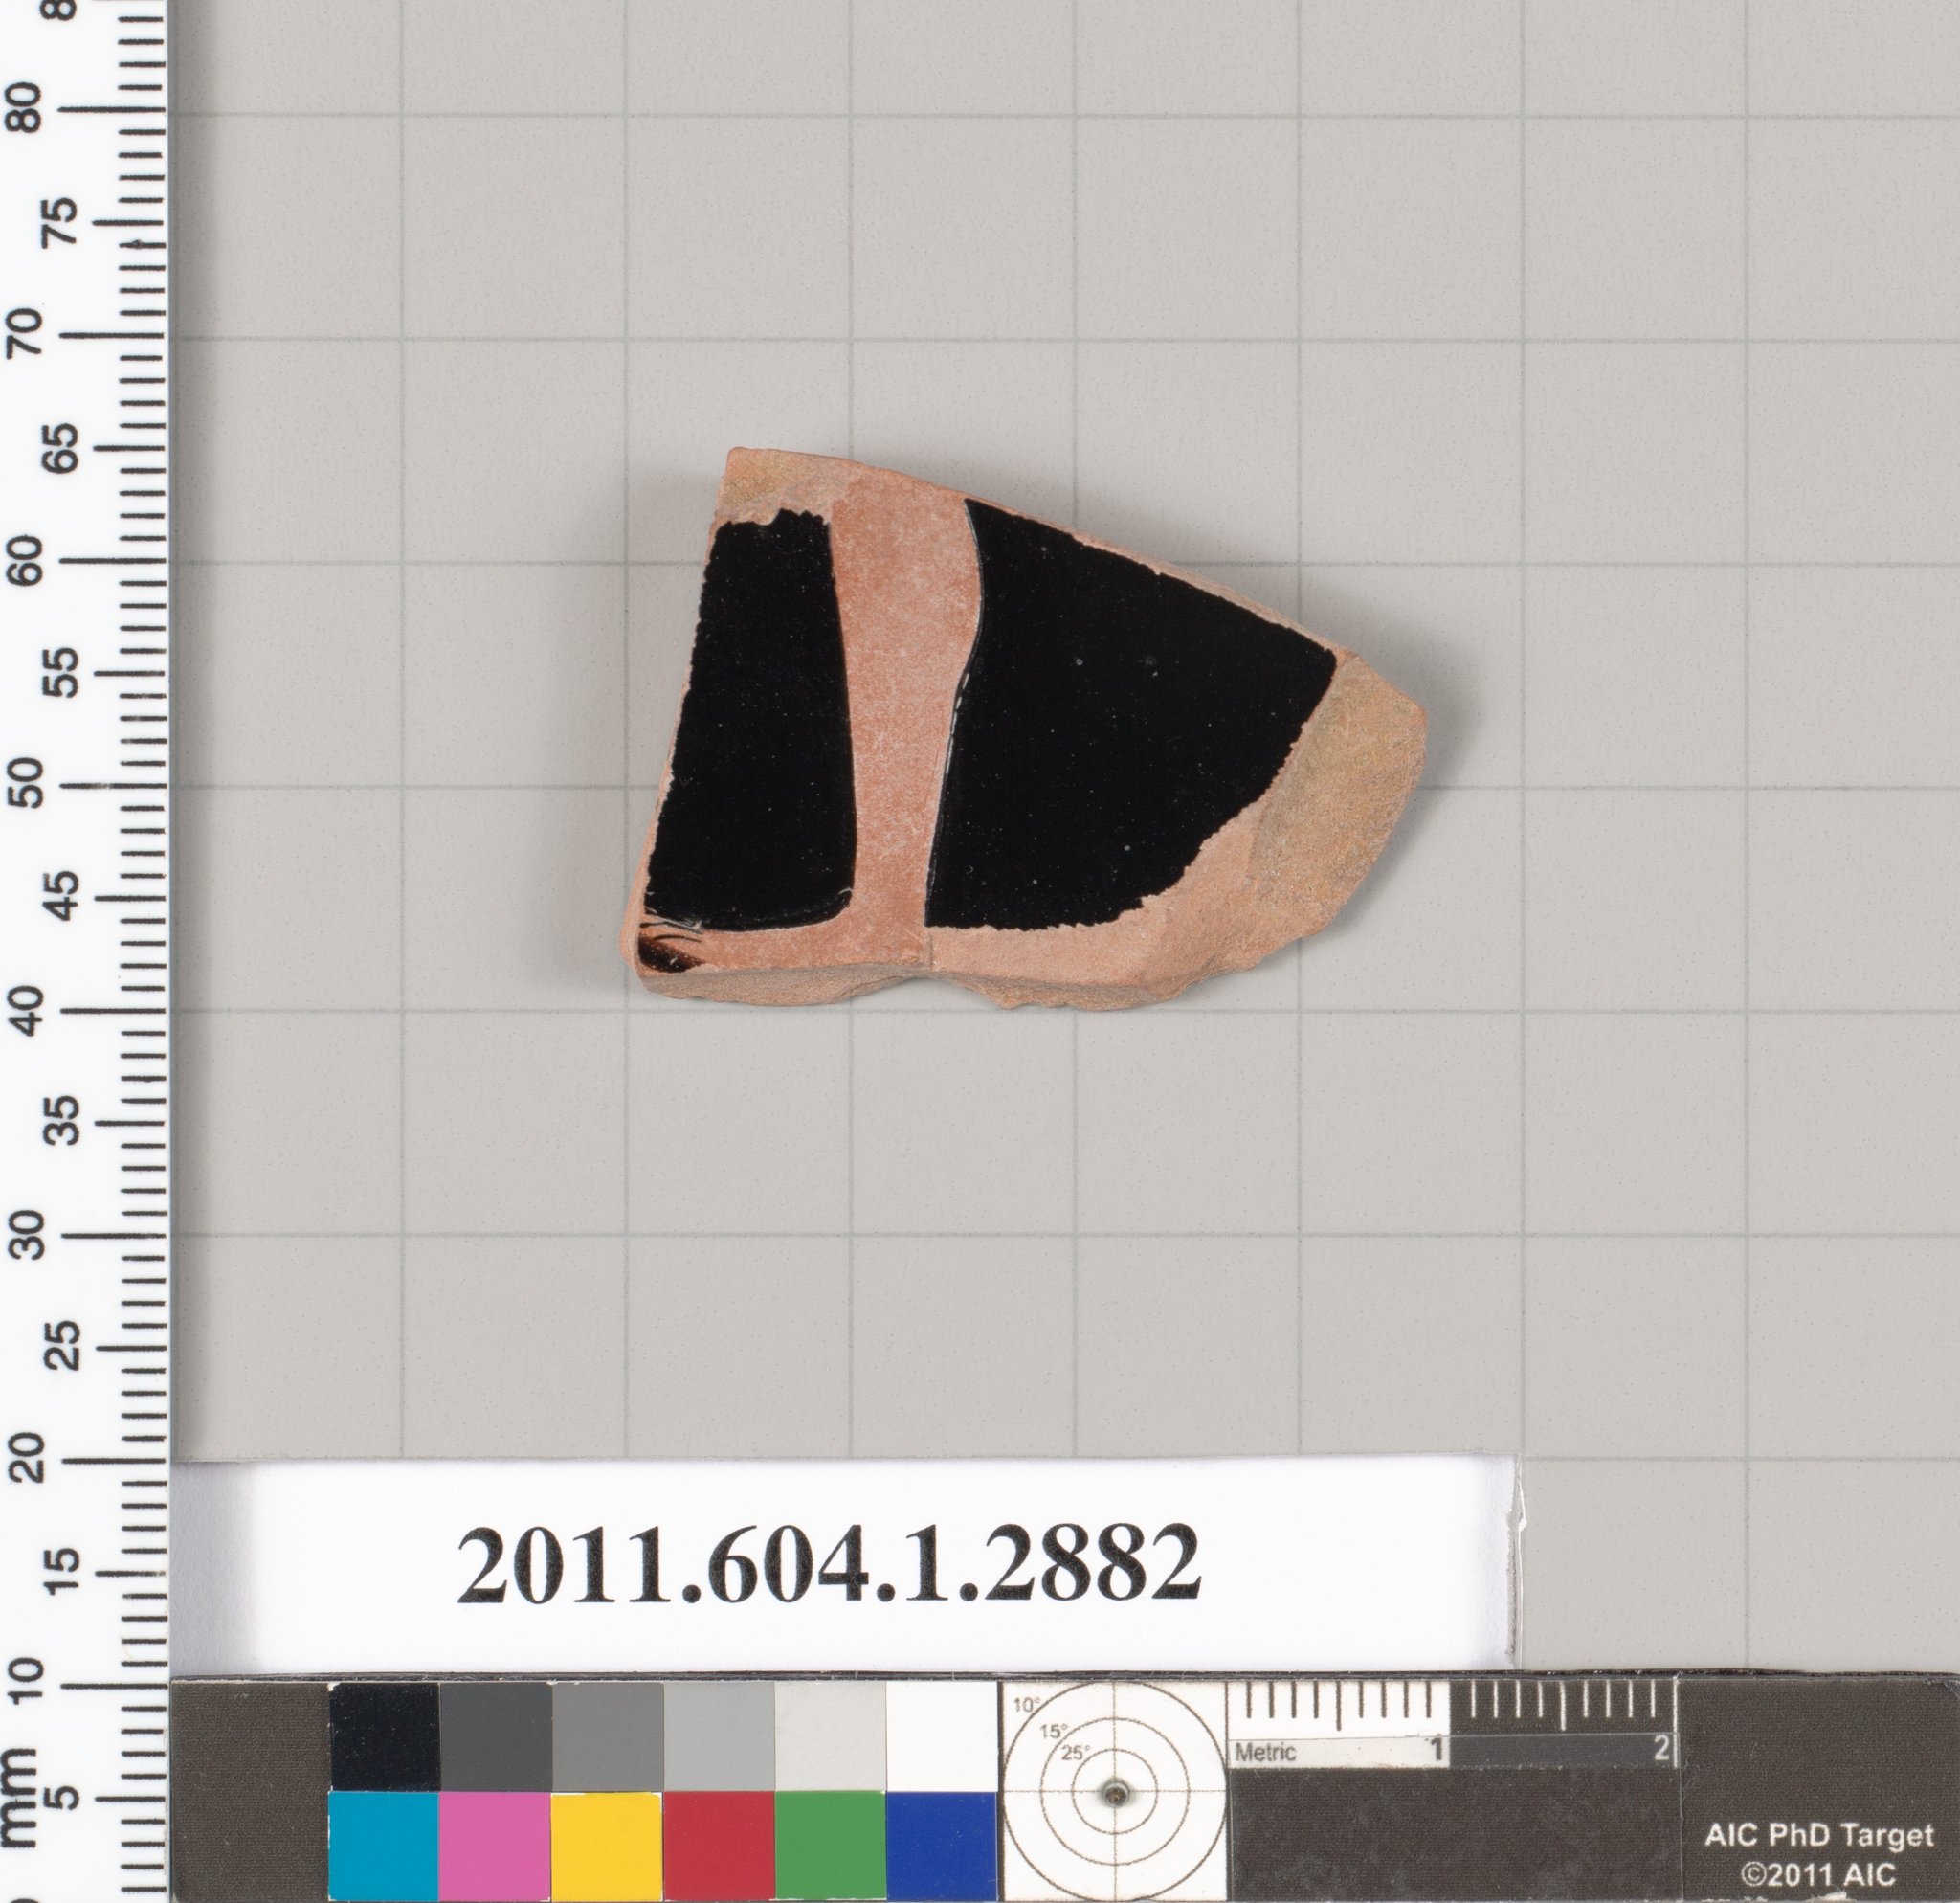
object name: kylix fragment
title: Terracotta fragment of a kylix (drinking cup)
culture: greek, attic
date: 510-490 BCE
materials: terracotta